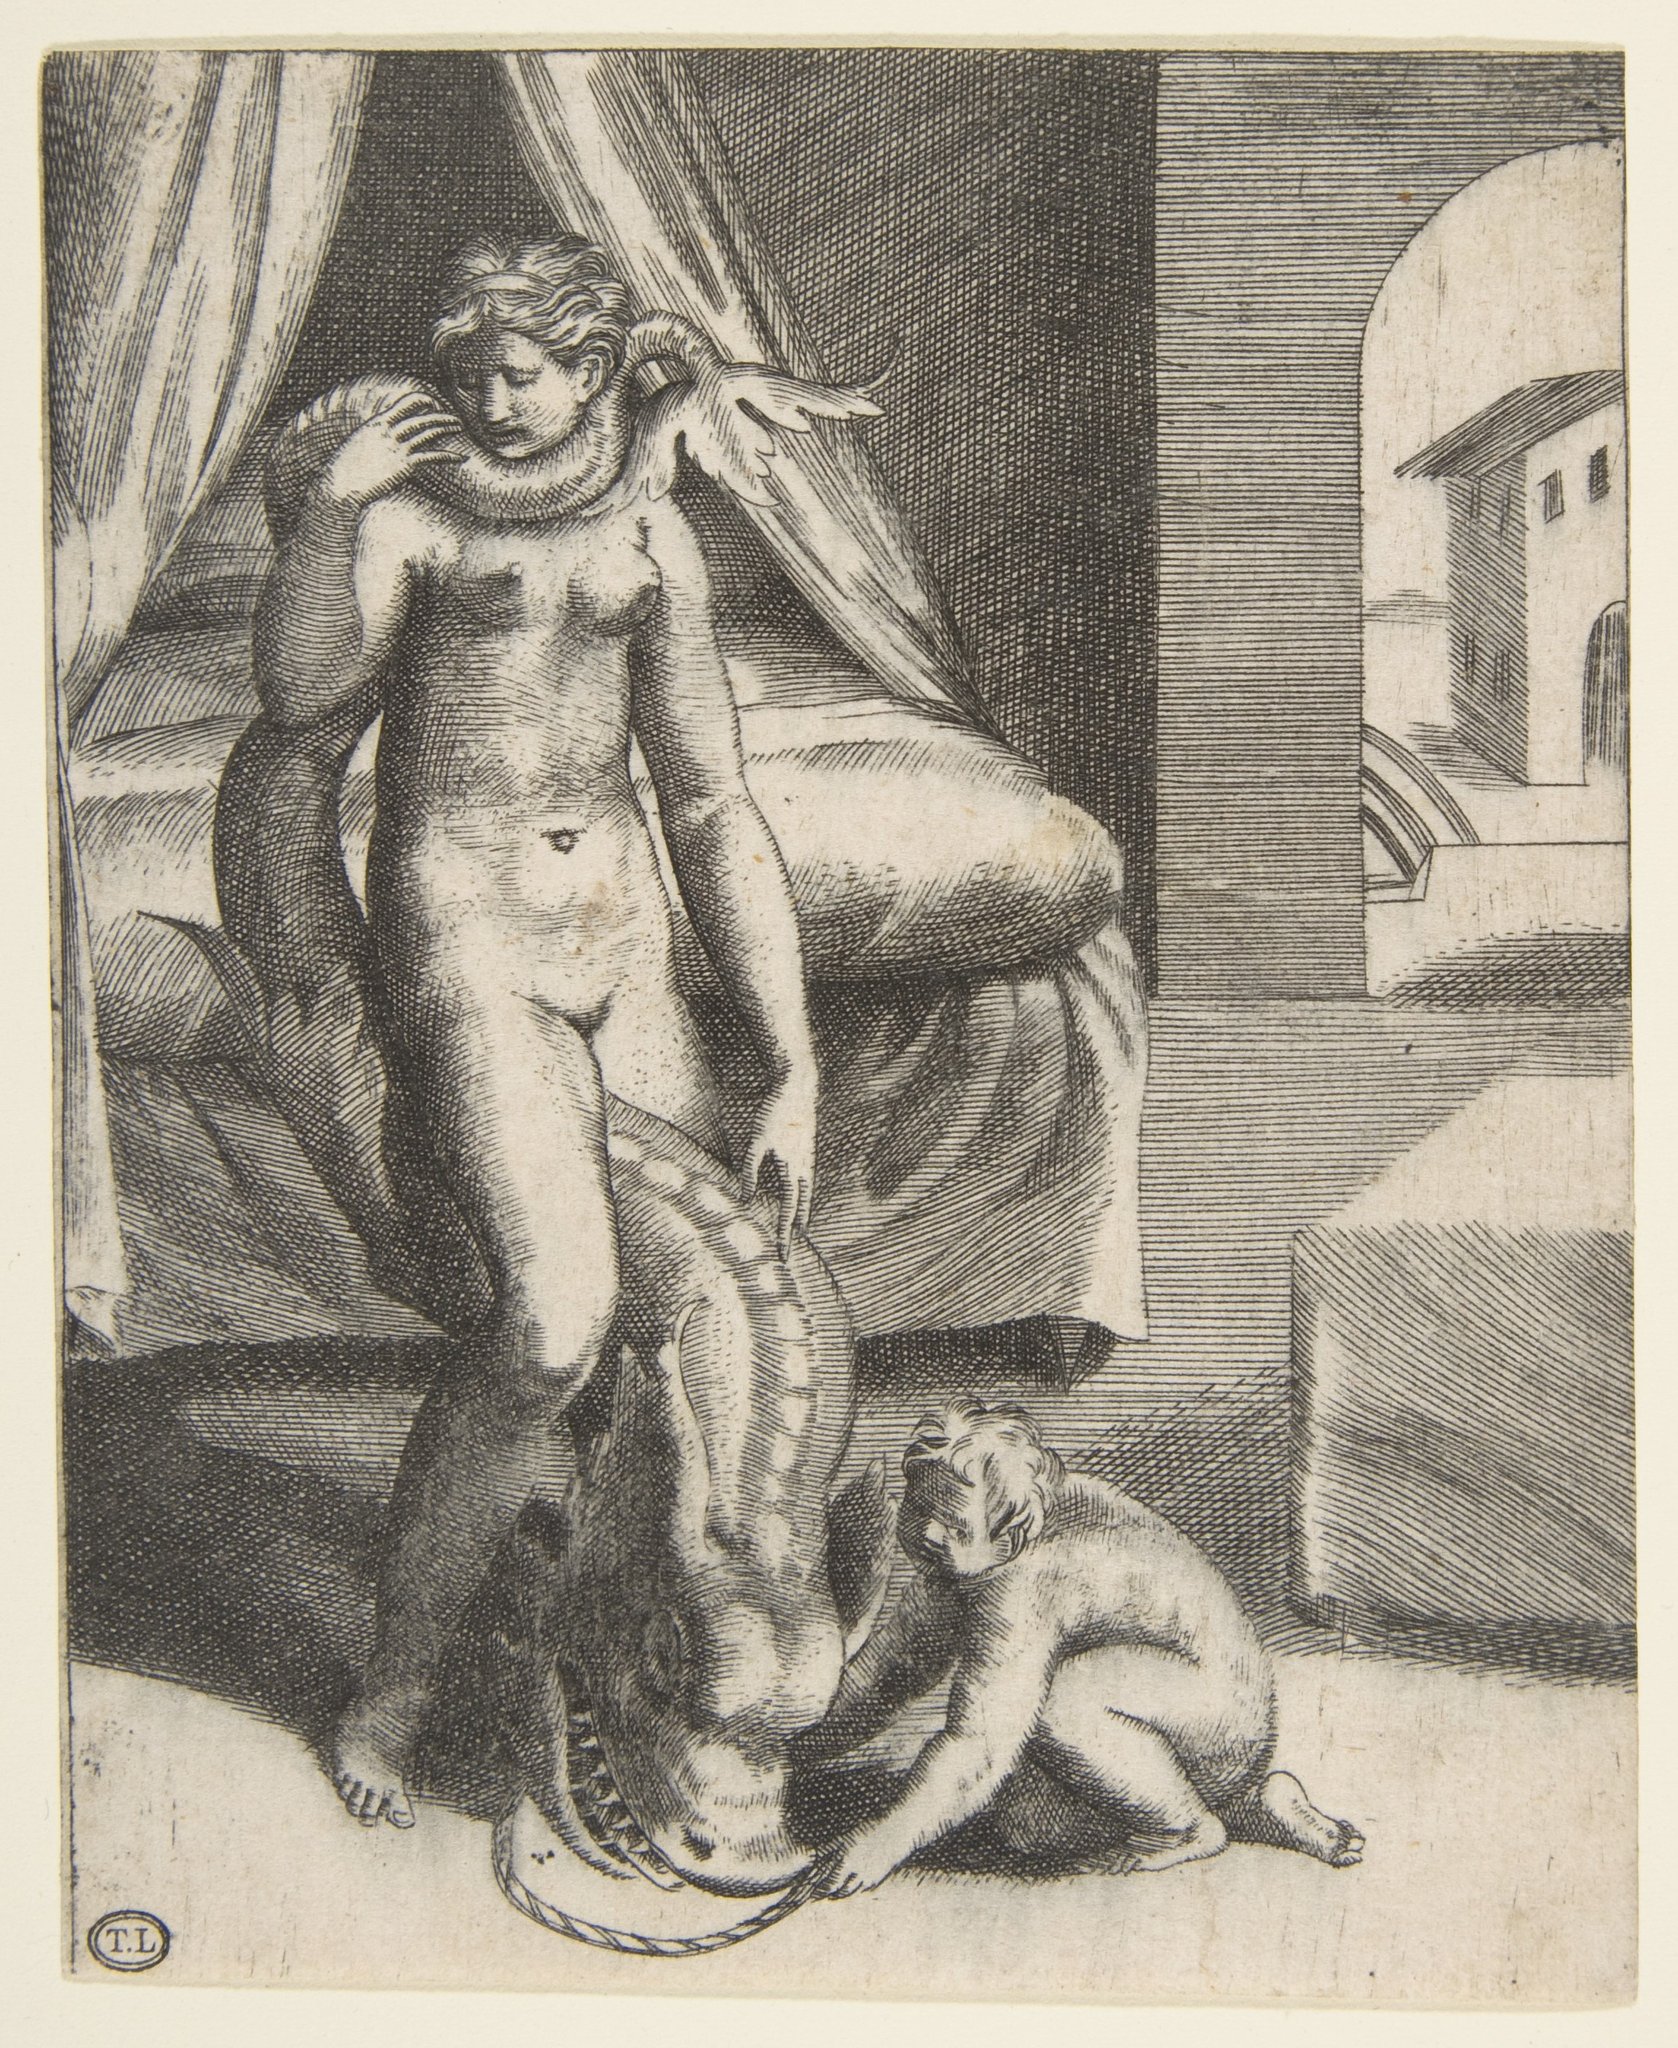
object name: print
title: Neptune and Melanthe, from "The Loves of the Gods" (Amorosi diletti degli dei)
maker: giulio bonasone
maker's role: artist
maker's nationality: italian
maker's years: 1510-1576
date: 1531-1576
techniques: engraving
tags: children,neptune